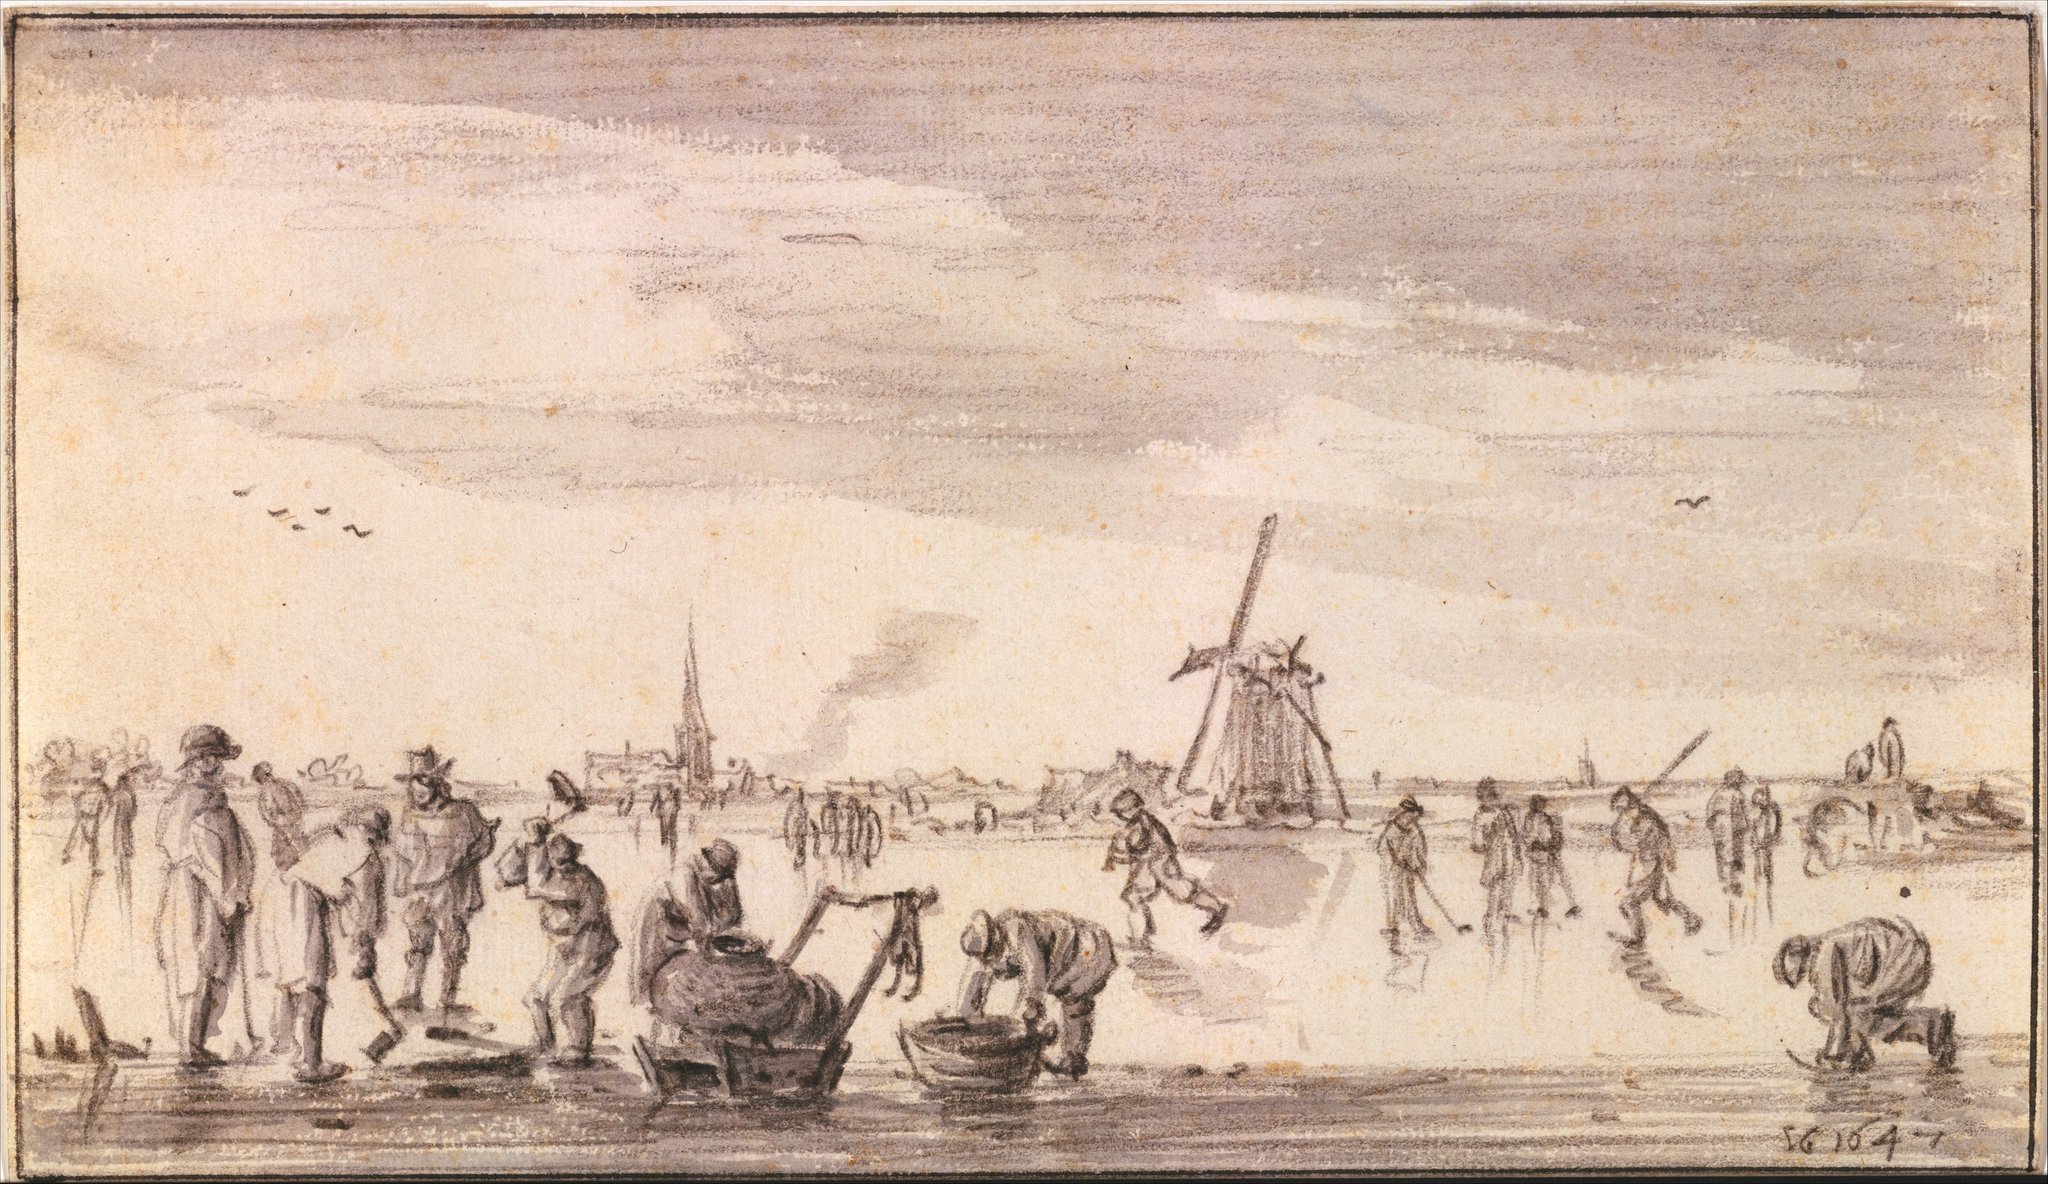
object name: drawing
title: Winter Landscape with Skaters and Fishermen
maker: jan van goyen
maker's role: artist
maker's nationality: dutch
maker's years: 1596-1656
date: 1647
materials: chalk, ink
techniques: brush, pen, wash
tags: windmills,men,skating,landscapes,winter